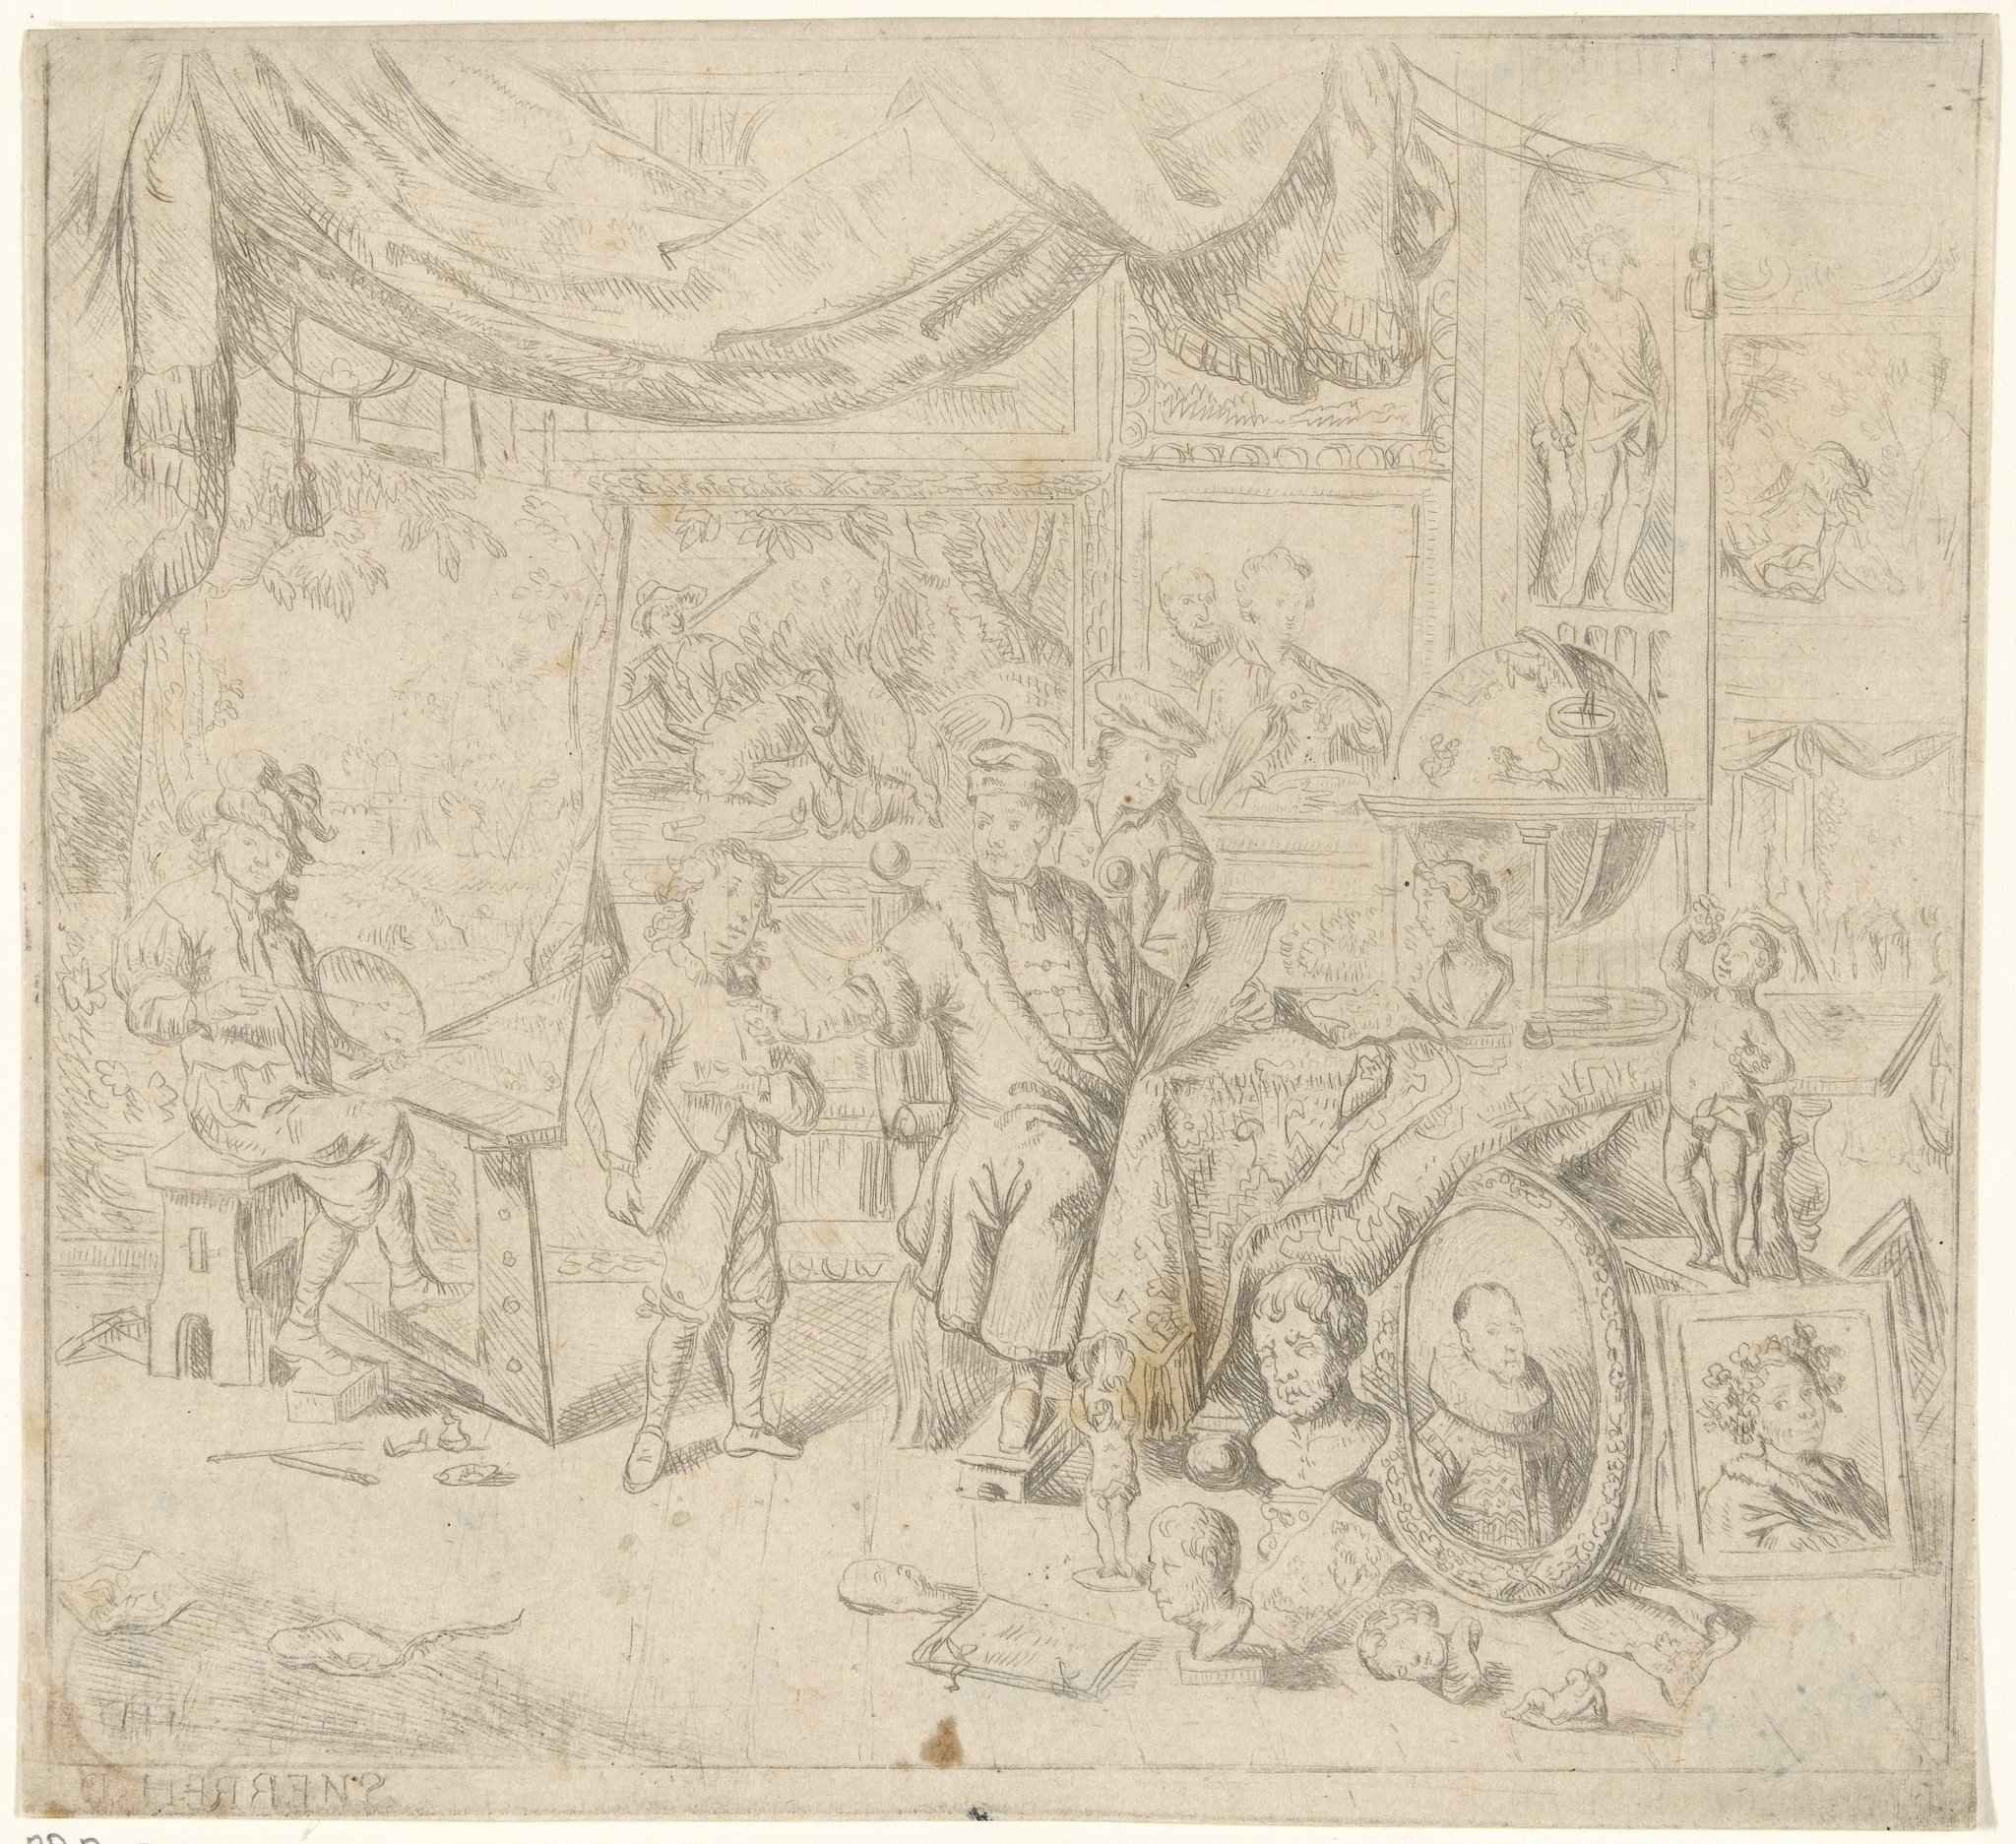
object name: print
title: Interieur van een kunstkabinet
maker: daniël herreyns (i)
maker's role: print maker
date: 1600-1649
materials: paper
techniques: etching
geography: antwerp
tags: 'gemalte galerie' (+ artist at work)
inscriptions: collector's mark: Lugt 2165, collector's mark: Lugt 514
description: Een schilder achter zijn ezel en een man aan een tafel in een interieur met vele schilderijen en kunstvoorwerpen.